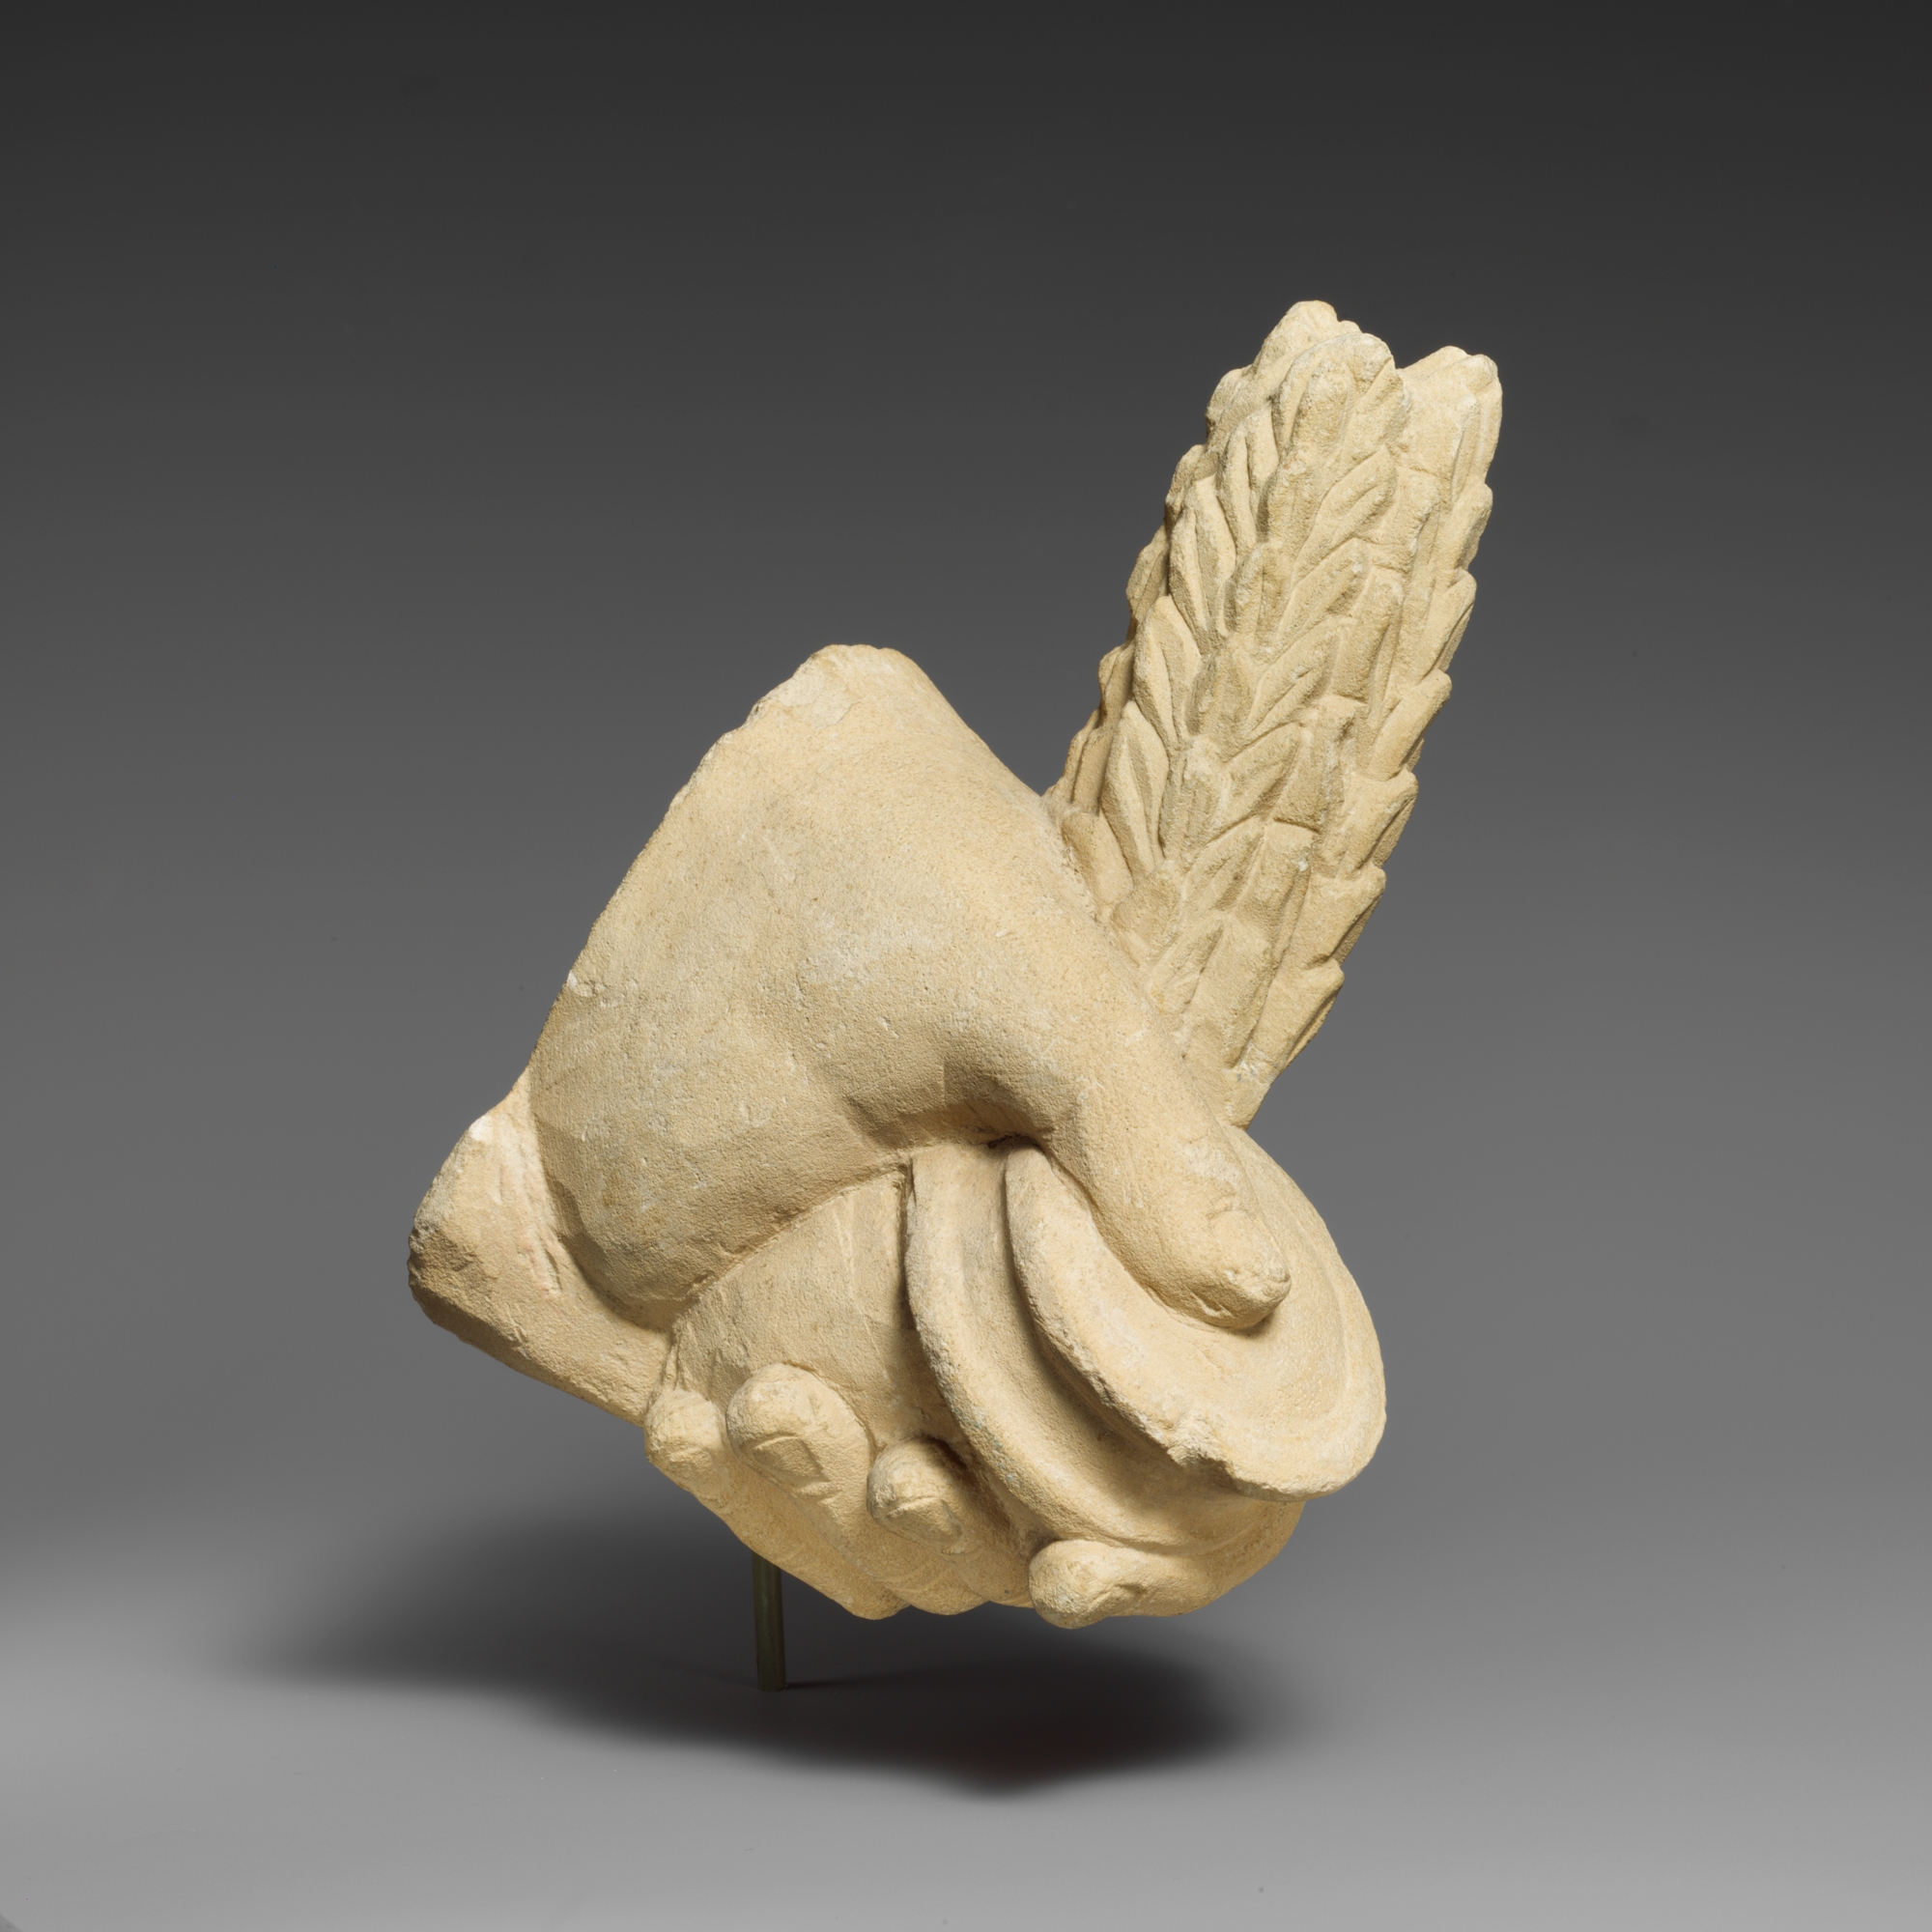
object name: hand, left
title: Limestone hand holding a pyxis and a branch of leaves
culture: cypriot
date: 300-1 BCE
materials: limestone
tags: hands,leaves